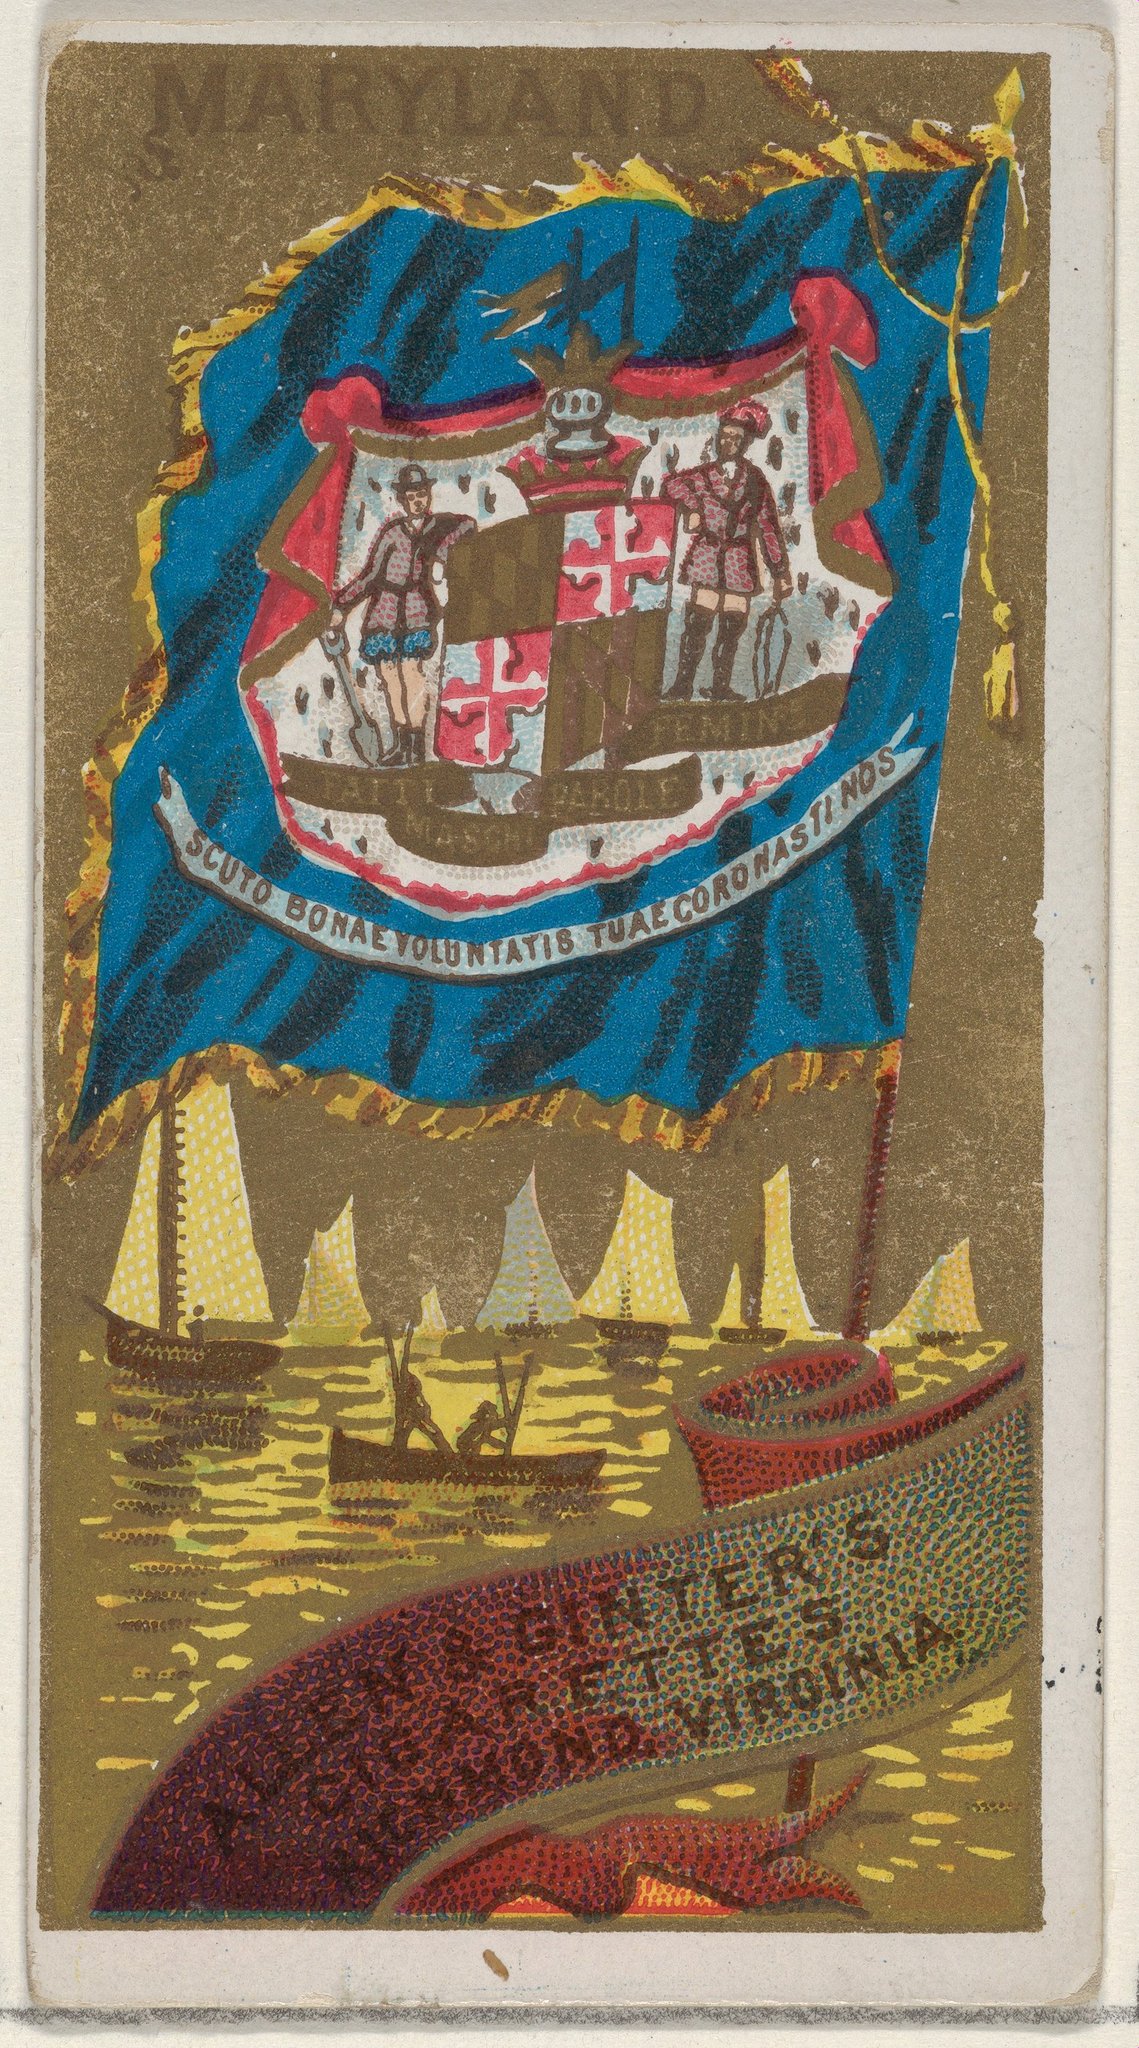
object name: print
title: Maryland, from Flags of the States and Territories (N11) for Allen & Ginter Cigarettes Brands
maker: allen & ginter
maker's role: publisher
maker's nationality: american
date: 1888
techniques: color lithograph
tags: flags